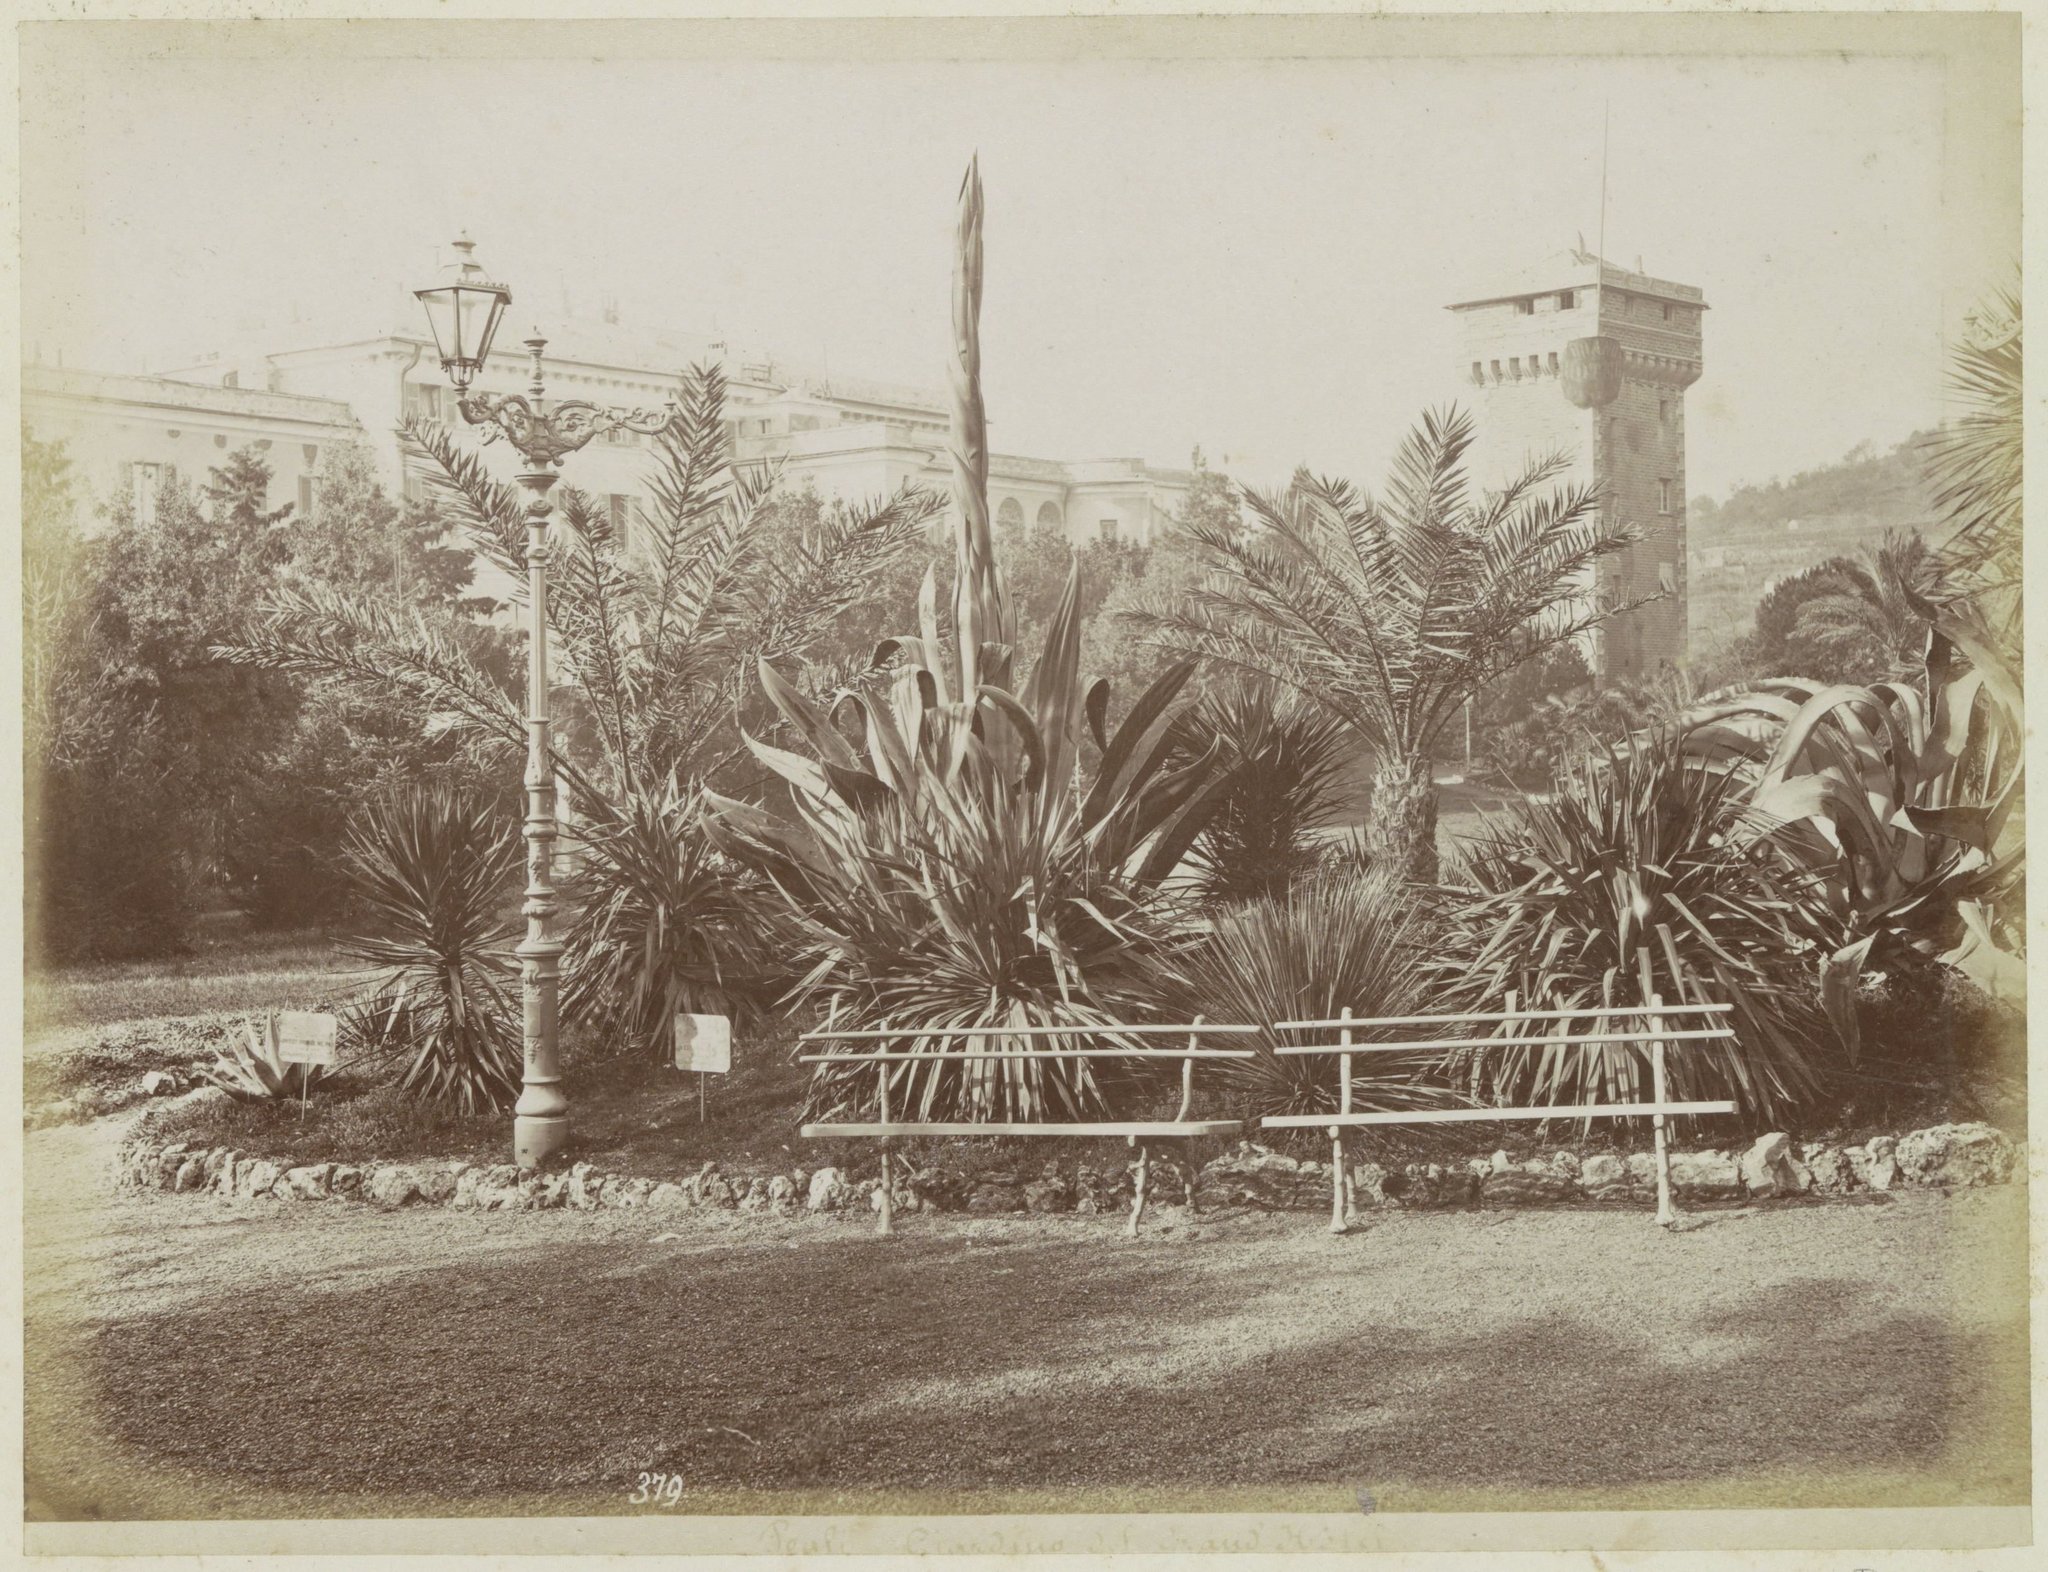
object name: photograph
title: Peali tuin bij het Grand Hotel, mogelijk in Florence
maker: Anonymous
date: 1870-1900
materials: paper, photographic support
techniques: albumen print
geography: florence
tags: public gardens, park (+ city(-scape) with figures, staffage)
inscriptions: negative number: ‘379’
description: Onderdeel van Reisalbum met foto's van bezienswaardigheden in Italië en Frankrijk.